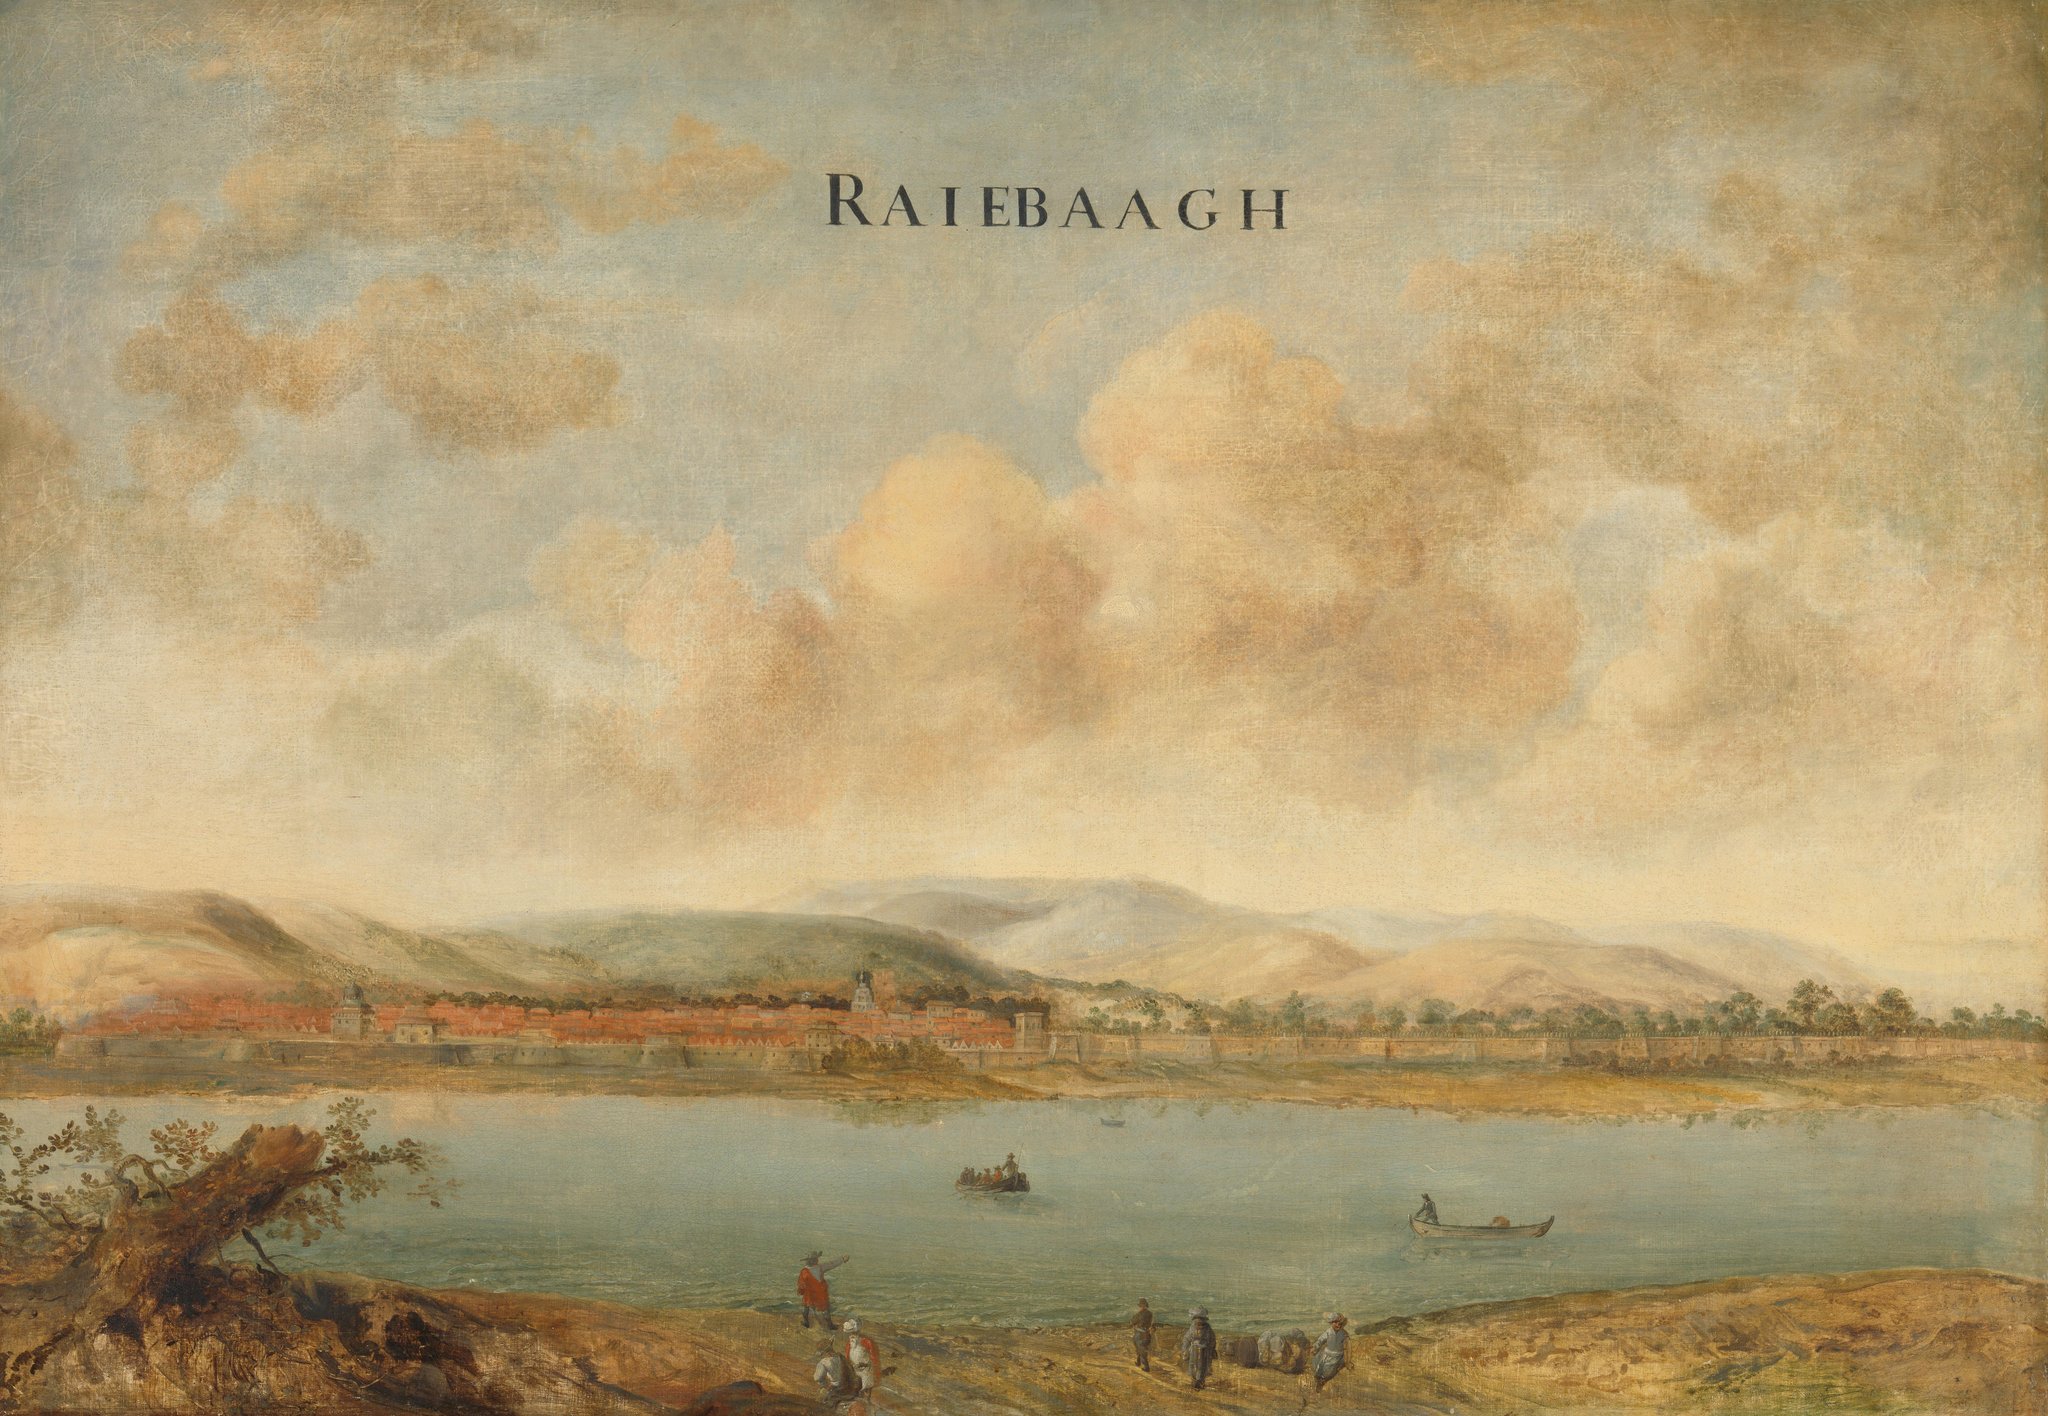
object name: painting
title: View of the City of Raiebaagh in Visiapoer, India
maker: johannes vinckboons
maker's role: draughtsman, print maker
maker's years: 1616-1670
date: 1662-1663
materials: canvas, oil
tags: river, locations for trading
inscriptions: inscription: ‘Raiebaagh’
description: Views of VOC bases, by David and Johannes Vingboons, 1663. By 1660, the VOC had built up an extensive network of trading bases. For the Company's headquarters at East India House, the directors commissioned a series of ten views of places in Asia where the VOC had established a foothold. Seven of these views have survived.